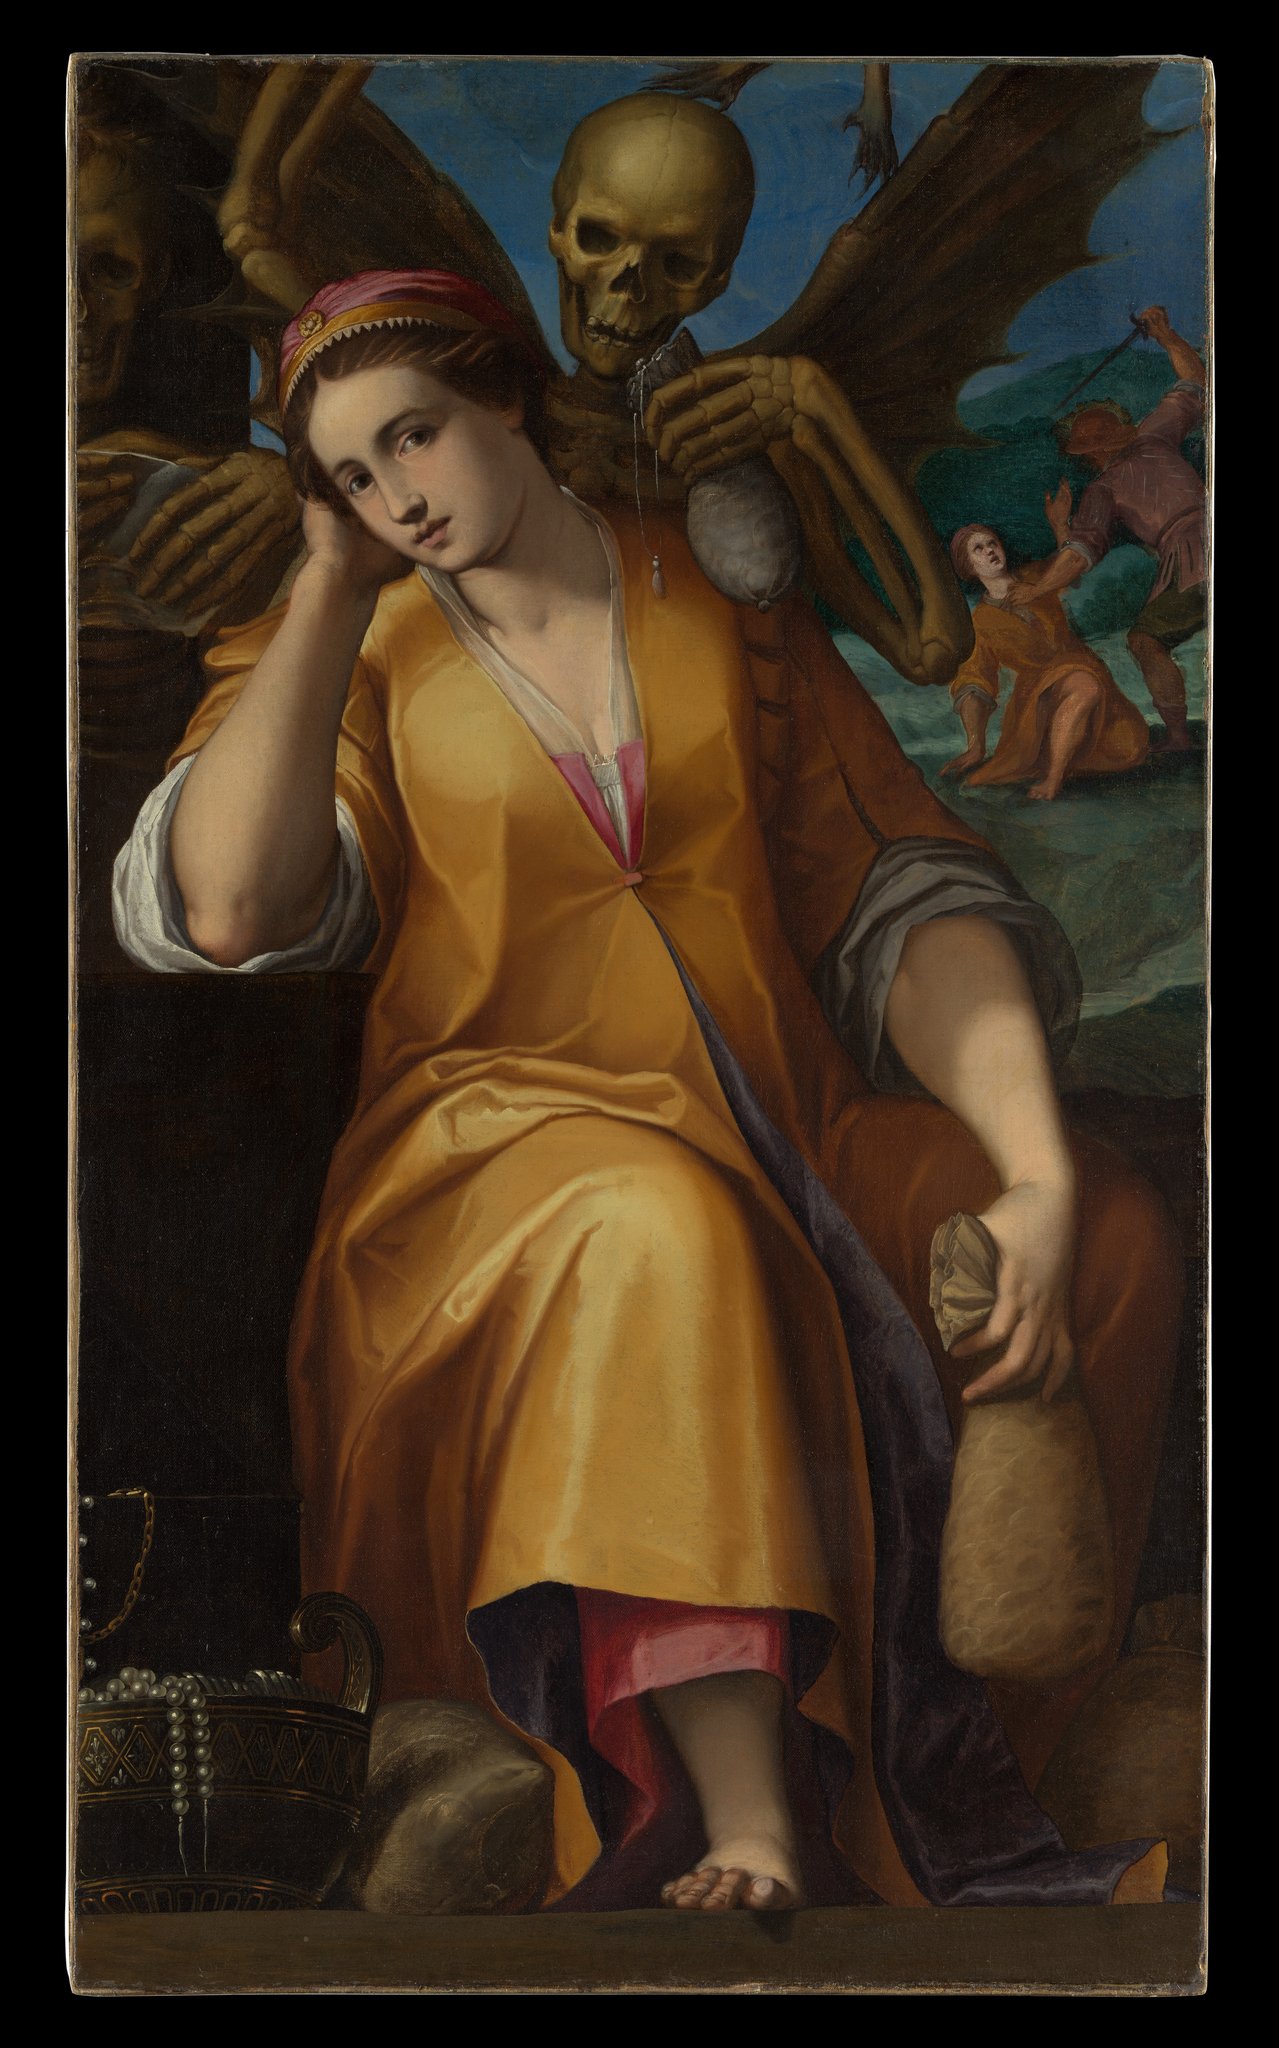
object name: painting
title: Allegory of Avarice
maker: jacopo ligozzi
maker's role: artist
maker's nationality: italian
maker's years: 1547-1627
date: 1567-1626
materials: canvas, oil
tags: skeletons,women,allegory